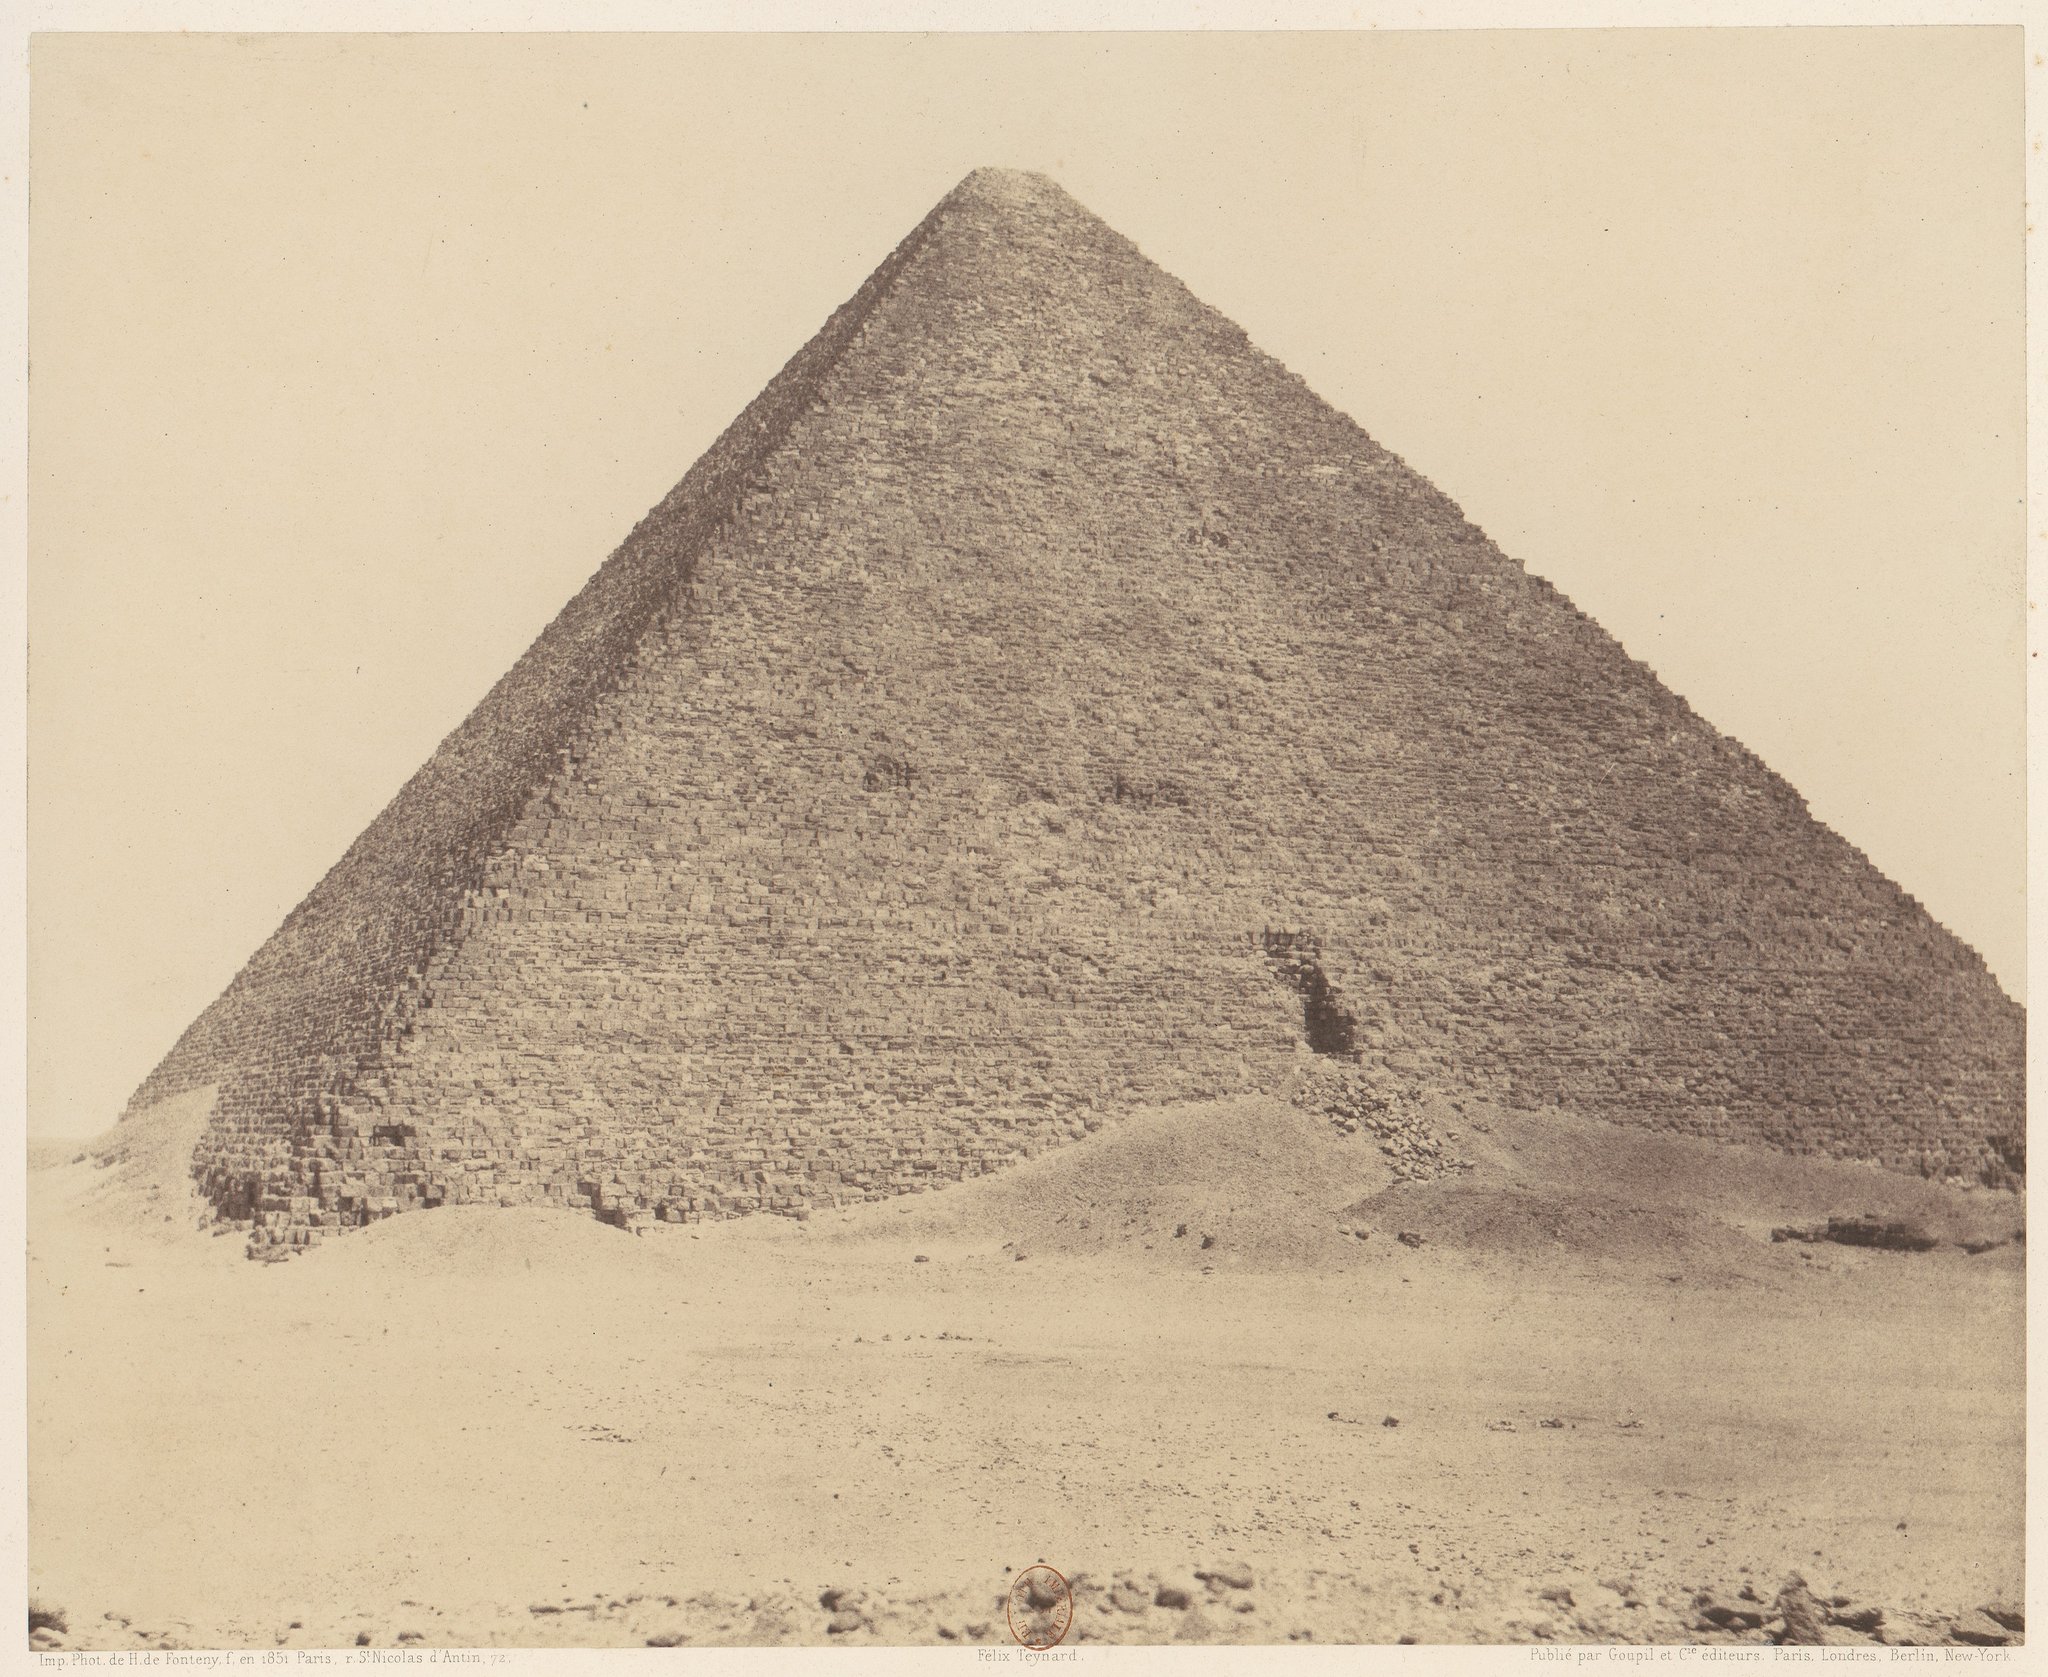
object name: photograph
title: Djîzeh (Nécropole de Memphis), Pyramide de Chéops (Grande Pyramide)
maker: félix teynard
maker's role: artist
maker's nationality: french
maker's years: 1817-1892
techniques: paper negative, salted paper print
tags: architecture,pyramids